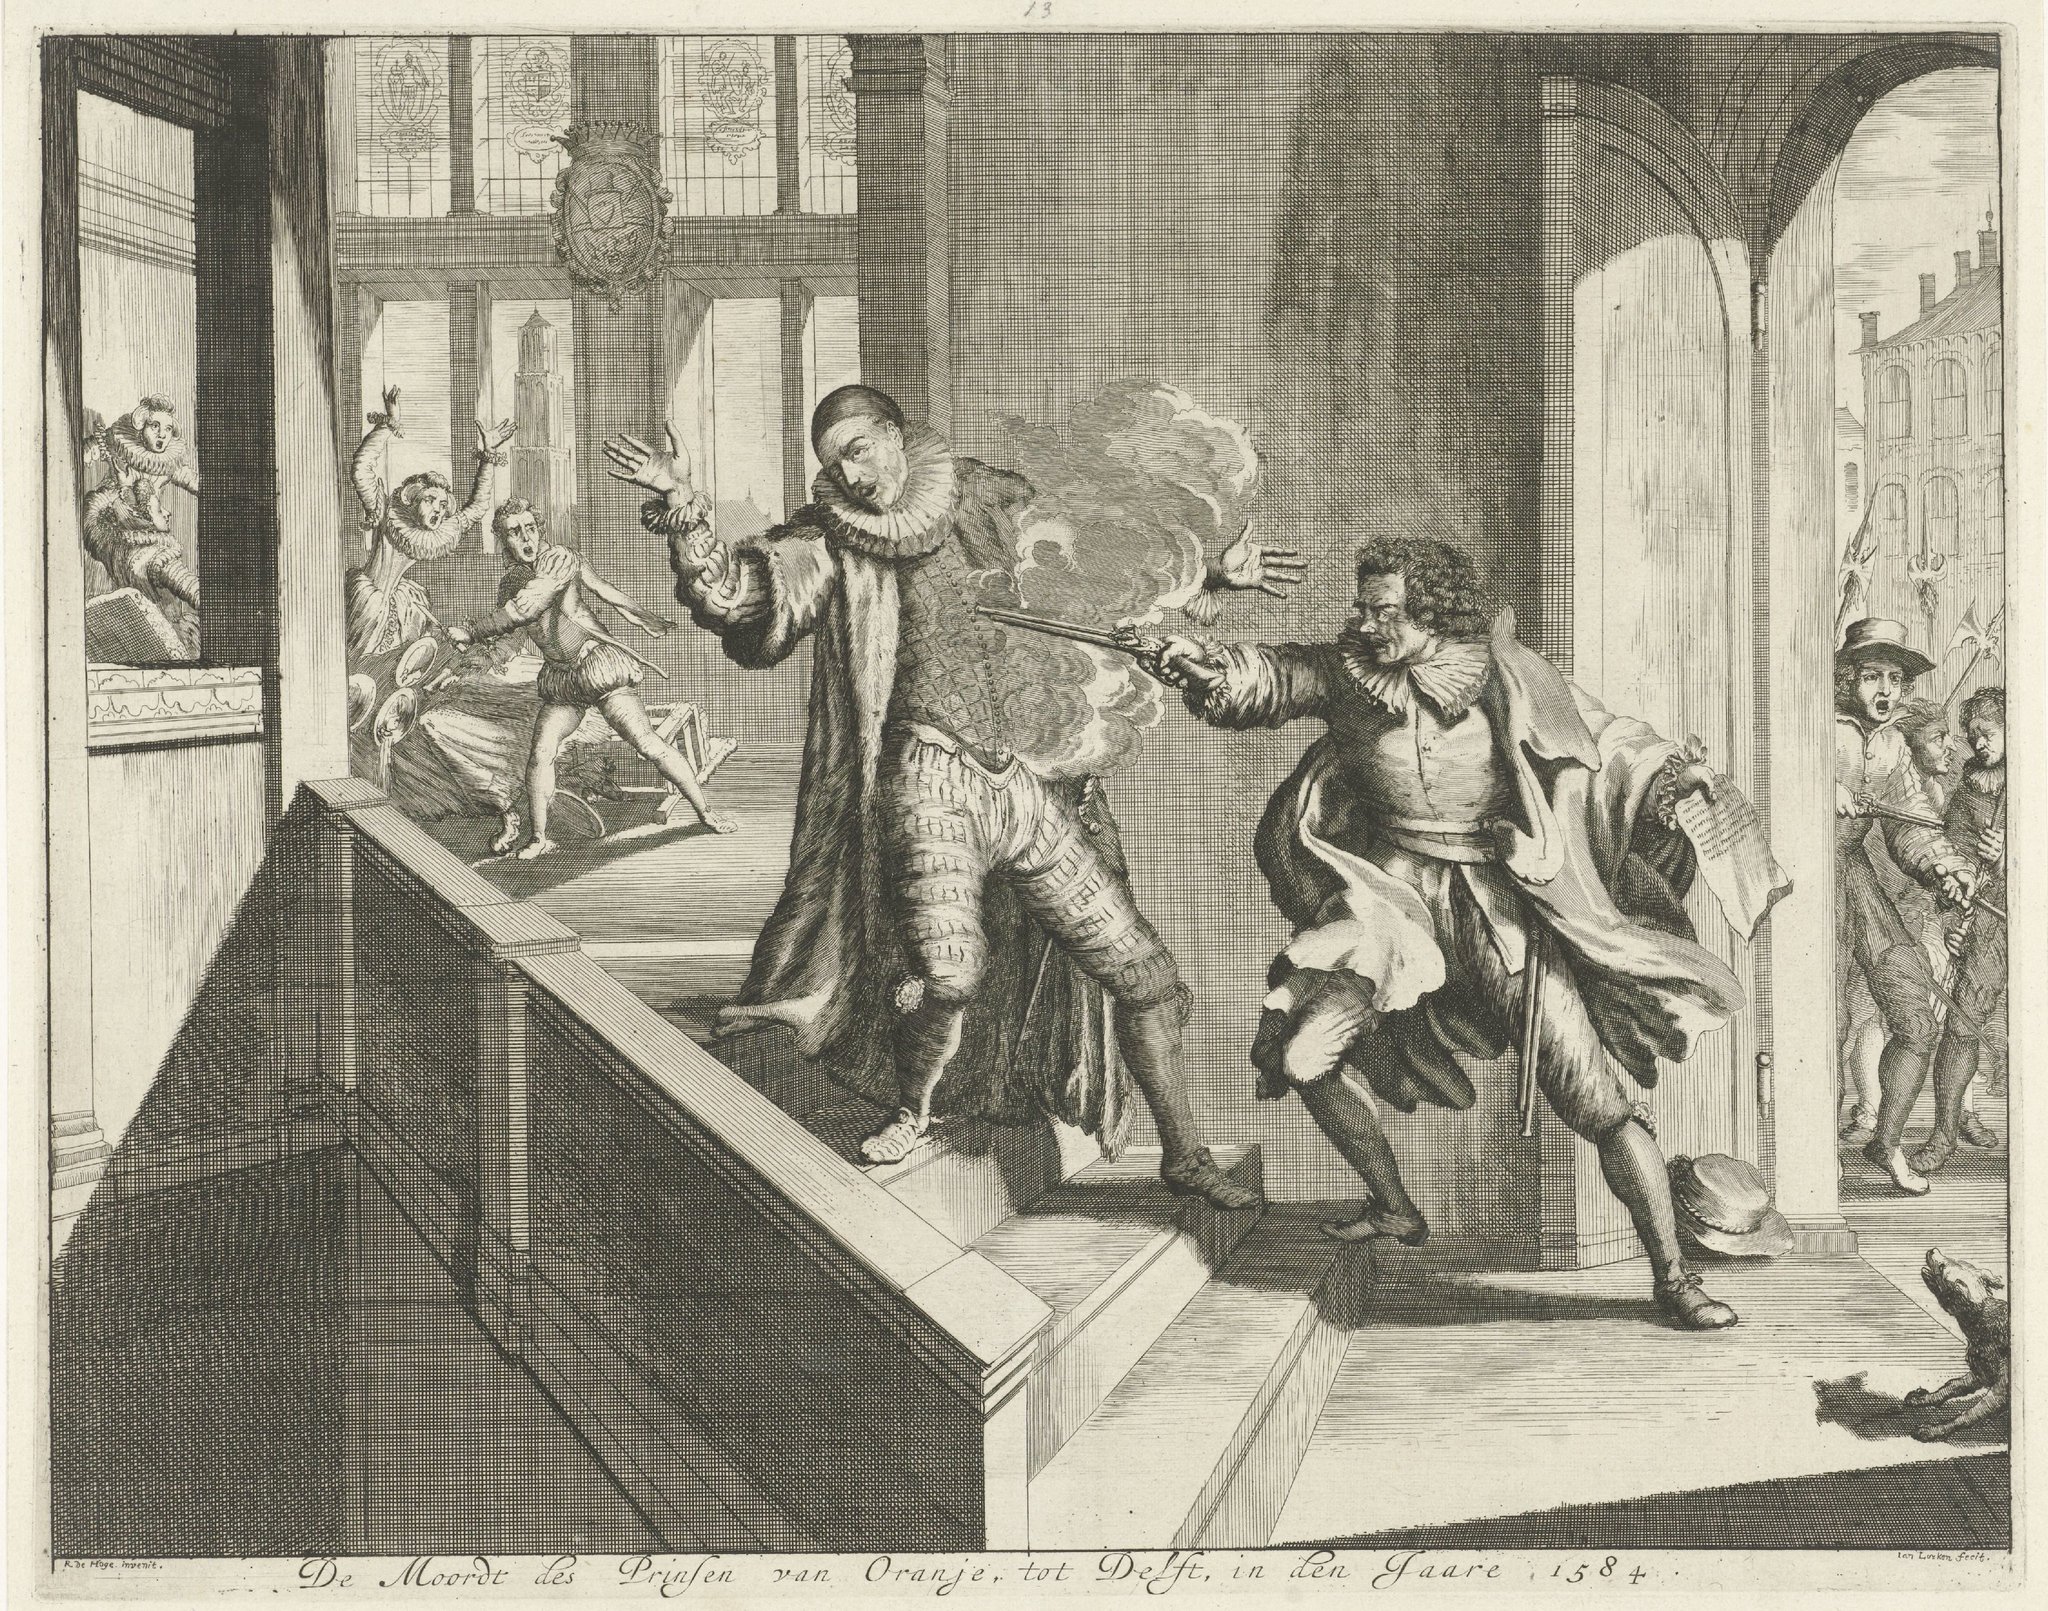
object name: print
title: De Moordt des Prinsen van Oranje, tot Delft, in den Jaare 1584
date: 1679-1684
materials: paper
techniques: etching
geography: amsterdam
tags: delft, william i (prince of orange), attempt, political murder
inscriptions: collector's mark: Lugt 2228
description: Illustratie gebruikt in: Bor Christiaansz, Pieter. Oorsprongk, begin, en vervolgh der Nederlandsche oorlogen, 4 delen. Amsterdam: weduwe Joannes van Someren, Abraham Wolfgang, Hendrick en Dirk Boom, 1679-1684, dl. II, p. 432.